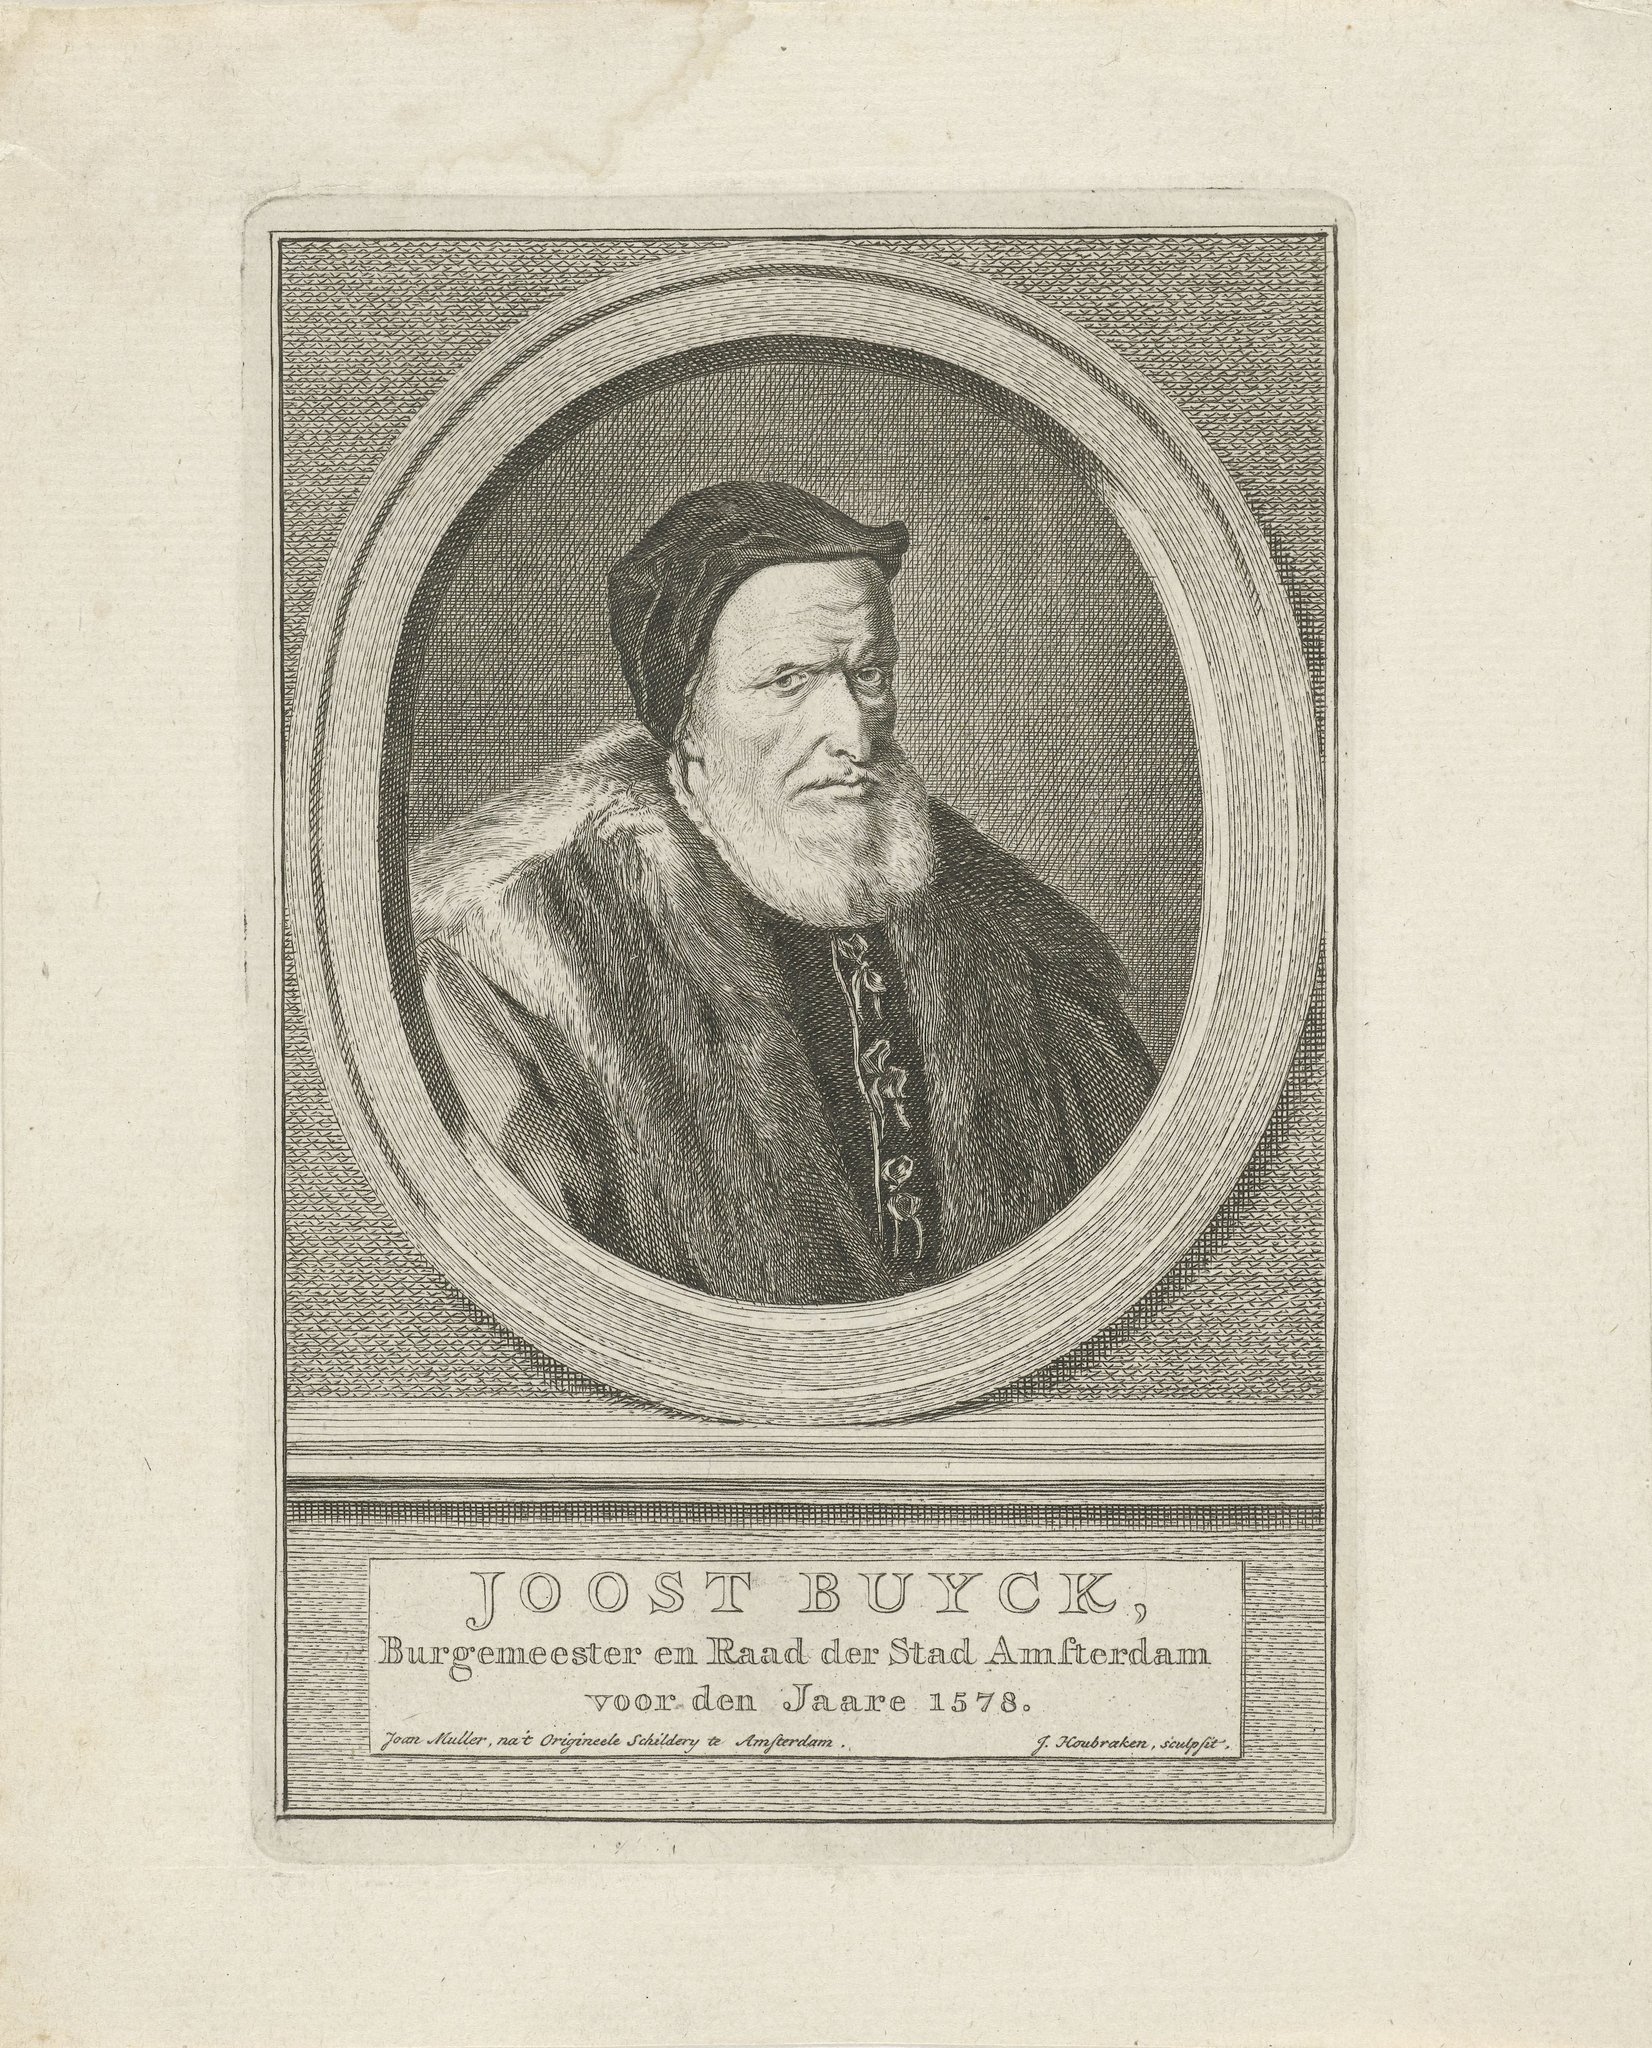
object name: print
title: Portret van Joost Sijbrandtsz. Buyck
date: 1749-1780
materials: paper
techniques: engraving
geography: amsterdam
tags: mayor, historical persons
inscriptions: collector's mark: Lugt 2228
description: Deze prent is oorspronkelijk bedoeld als aanvulling op Jan Wagenaars ‘Vaderlandsche historie’* en was zo vanaf 1796 verkrijgbaar bij Johannes Allart te Amsterdam. Voor de advertentie waarin Allart de 60 portretten en 7 platen, allen gegraveerd door Houbraken, ter aanvulling op Wagenaars ‘Vaderlandsche historie’ aanbiedt, zie RP-P-OB-77.766. *Van dit werk zijn in de achttiende eeuw meerdere uitgaves verschenen, zoals: Wagenaar, Jan. Vaderlandsche historie, vervattende de geschiedenissen der Vereenigde Nederlanden (…). 21 delen. Amsterdam: Isaak Tirion, 1749-1759. Wagenaar, Jan. Vaderlandsche historie, vervattende de geschiedenissen der nu Vereenigde Nederlanden (…). 21 delen. Amsterdam: weduwe Isaak Tirion, 1770. Wagenaar, Jan. Vaderlandsche historie, vervattende de geschiedenissen der nu Vereenigde Nederlanden (…). 21 delen. Amsterdam, Leiden, Dordrecht en Harlingen: P. Schouten e.a., 1782. Wagenaar, Jan. Vaderlandsche historie, vervattende de geschiedenissen der nu Vereenigde Nederlanden (…). 21 delen. Amsterdam: Johannes Allart, 1790-1796.